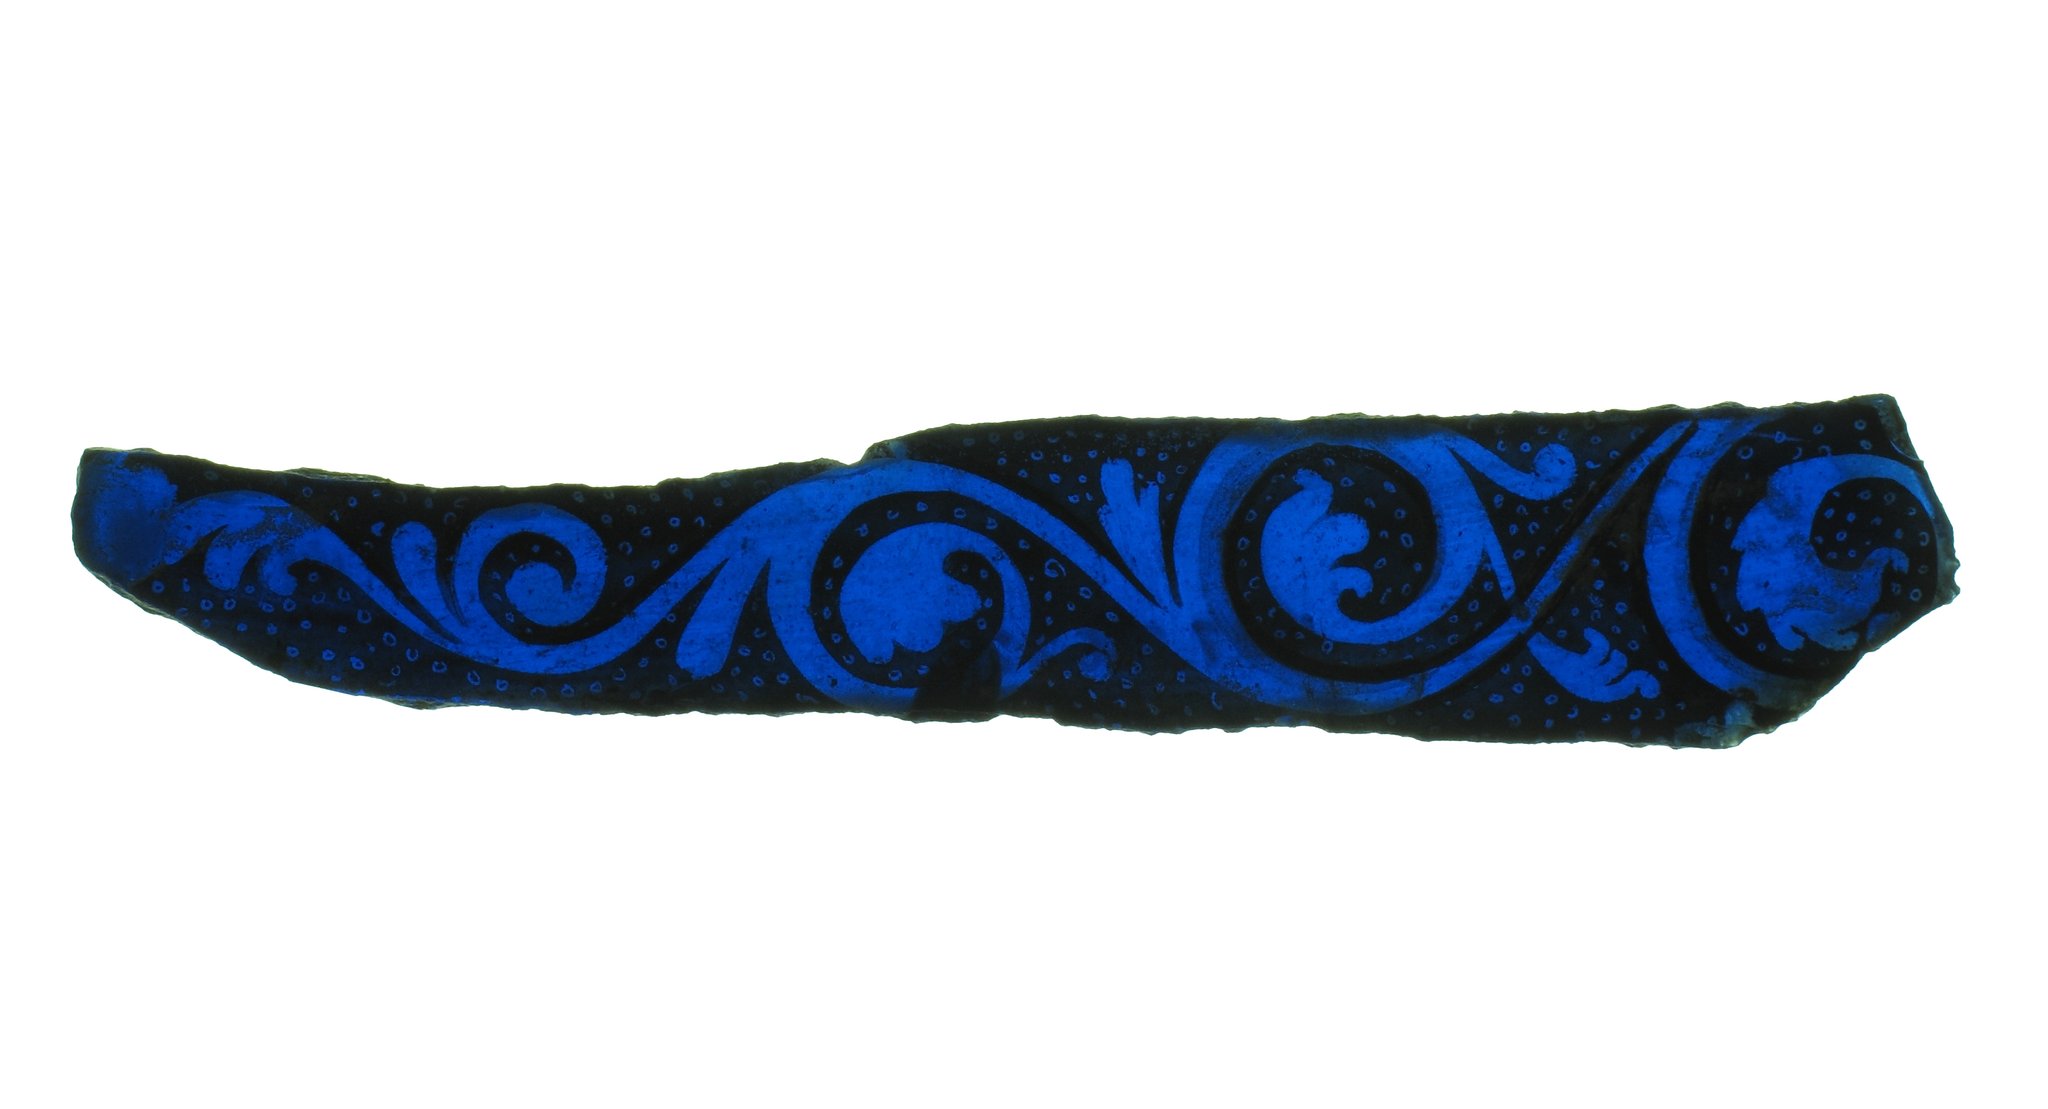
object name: fragment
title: Glass Fragment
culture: french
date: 1101-1400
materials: glass, metal, paint